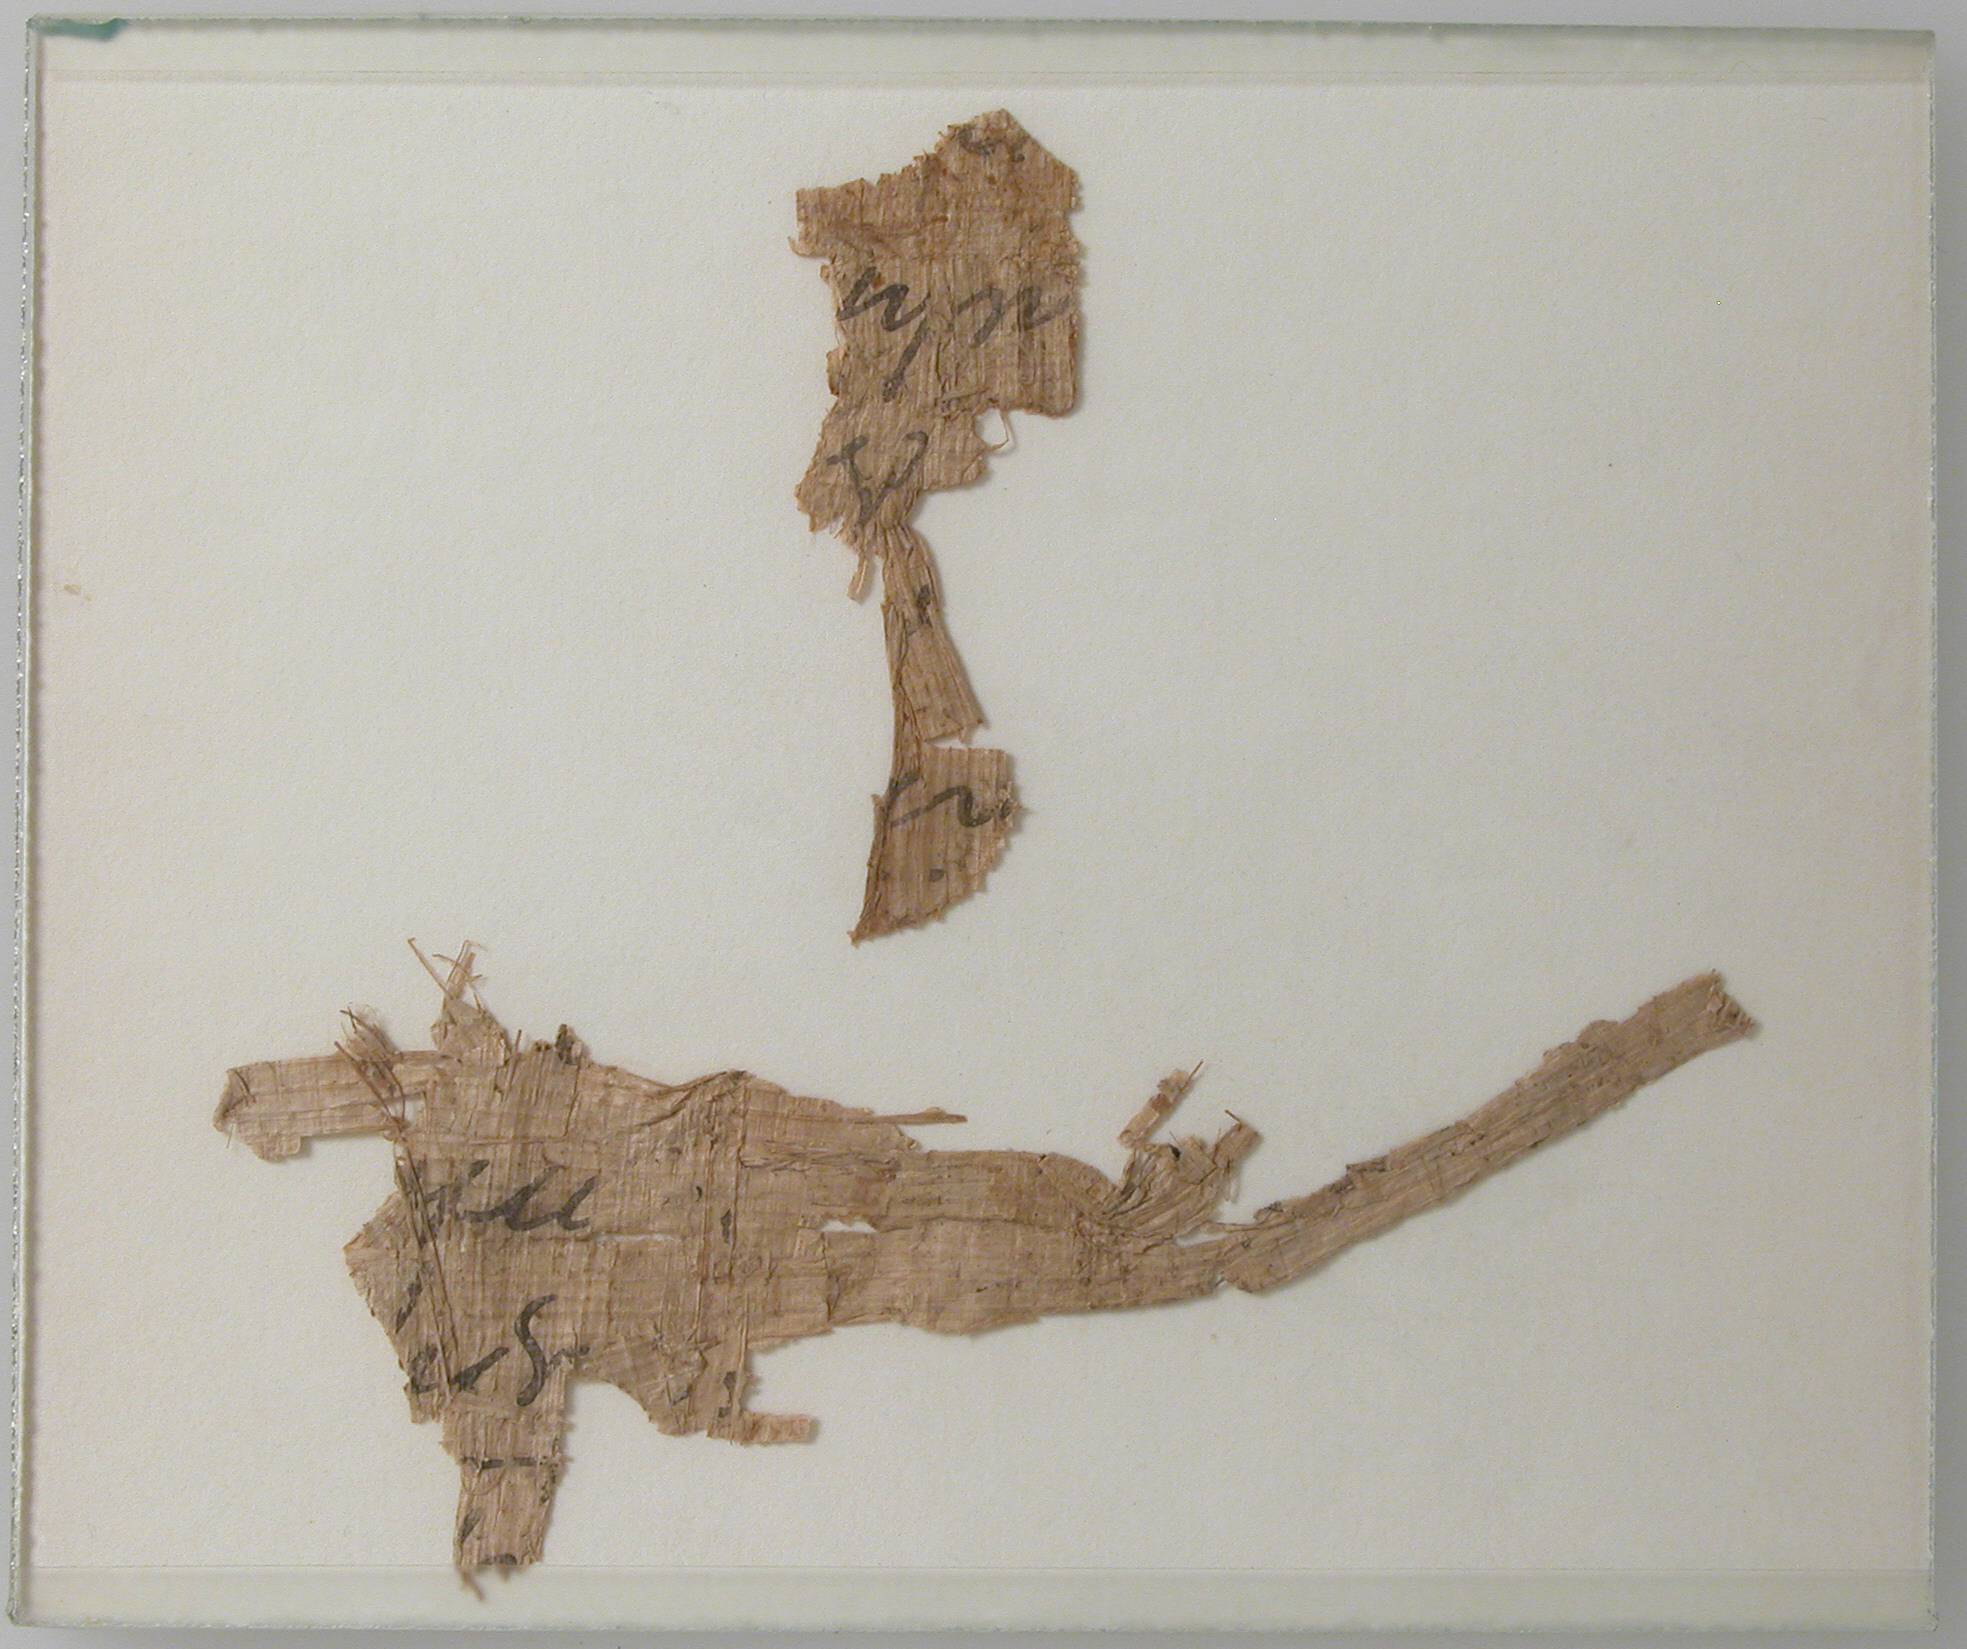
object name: fragment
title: Papyri Fragments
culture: coptic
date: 600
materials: ink, papyrus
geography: egypt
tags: documents